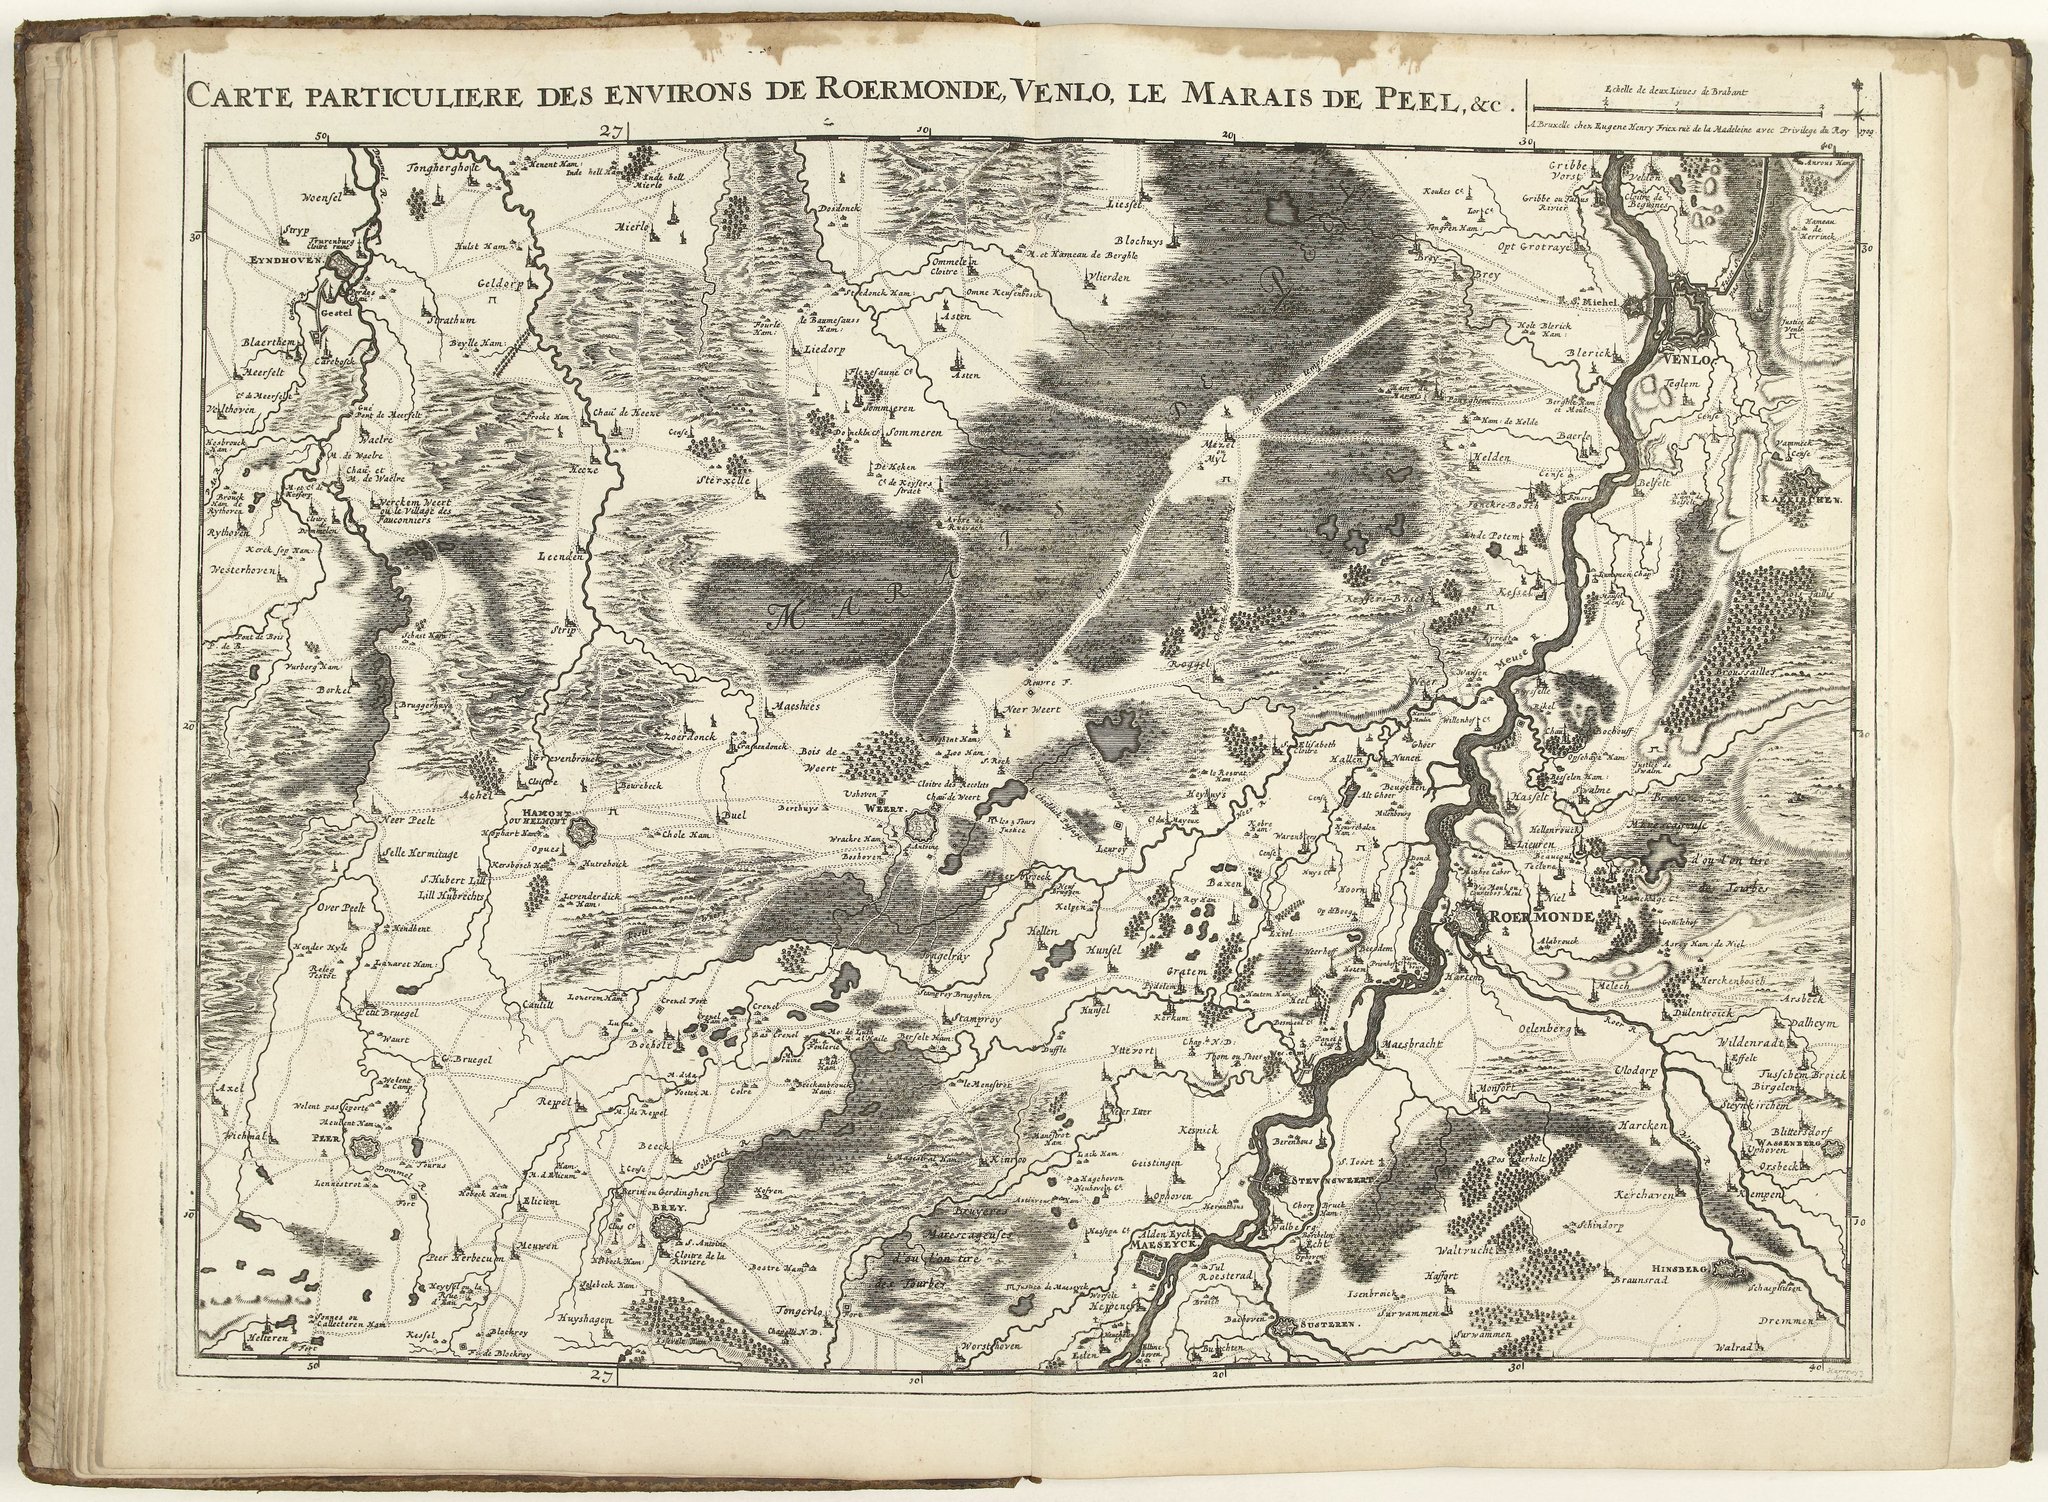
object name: map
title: Carte particuliere des environs de Roermonde, Venlo, le Marais de Peel, &c.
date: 1709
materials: paper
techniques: engraving, etching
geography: brussels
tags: maps of separate countries or regions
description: Kaart van de omgeving van Roermond en Venlo met de Peel, 1709. Onderdeel van een gebundelde verzameling van plannen van veldslagen en steden vermaard in de Spaanse Successieoorlog. Deze plaat behoort tot de eerste 24 platen die samen een zeer grote kaart van de Zuidelijke Nederlanden vormen.